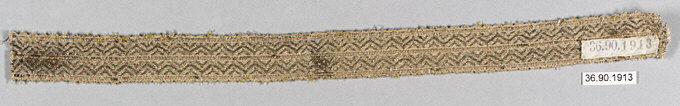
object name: galloon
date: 1801-1900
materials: metal thread, silk